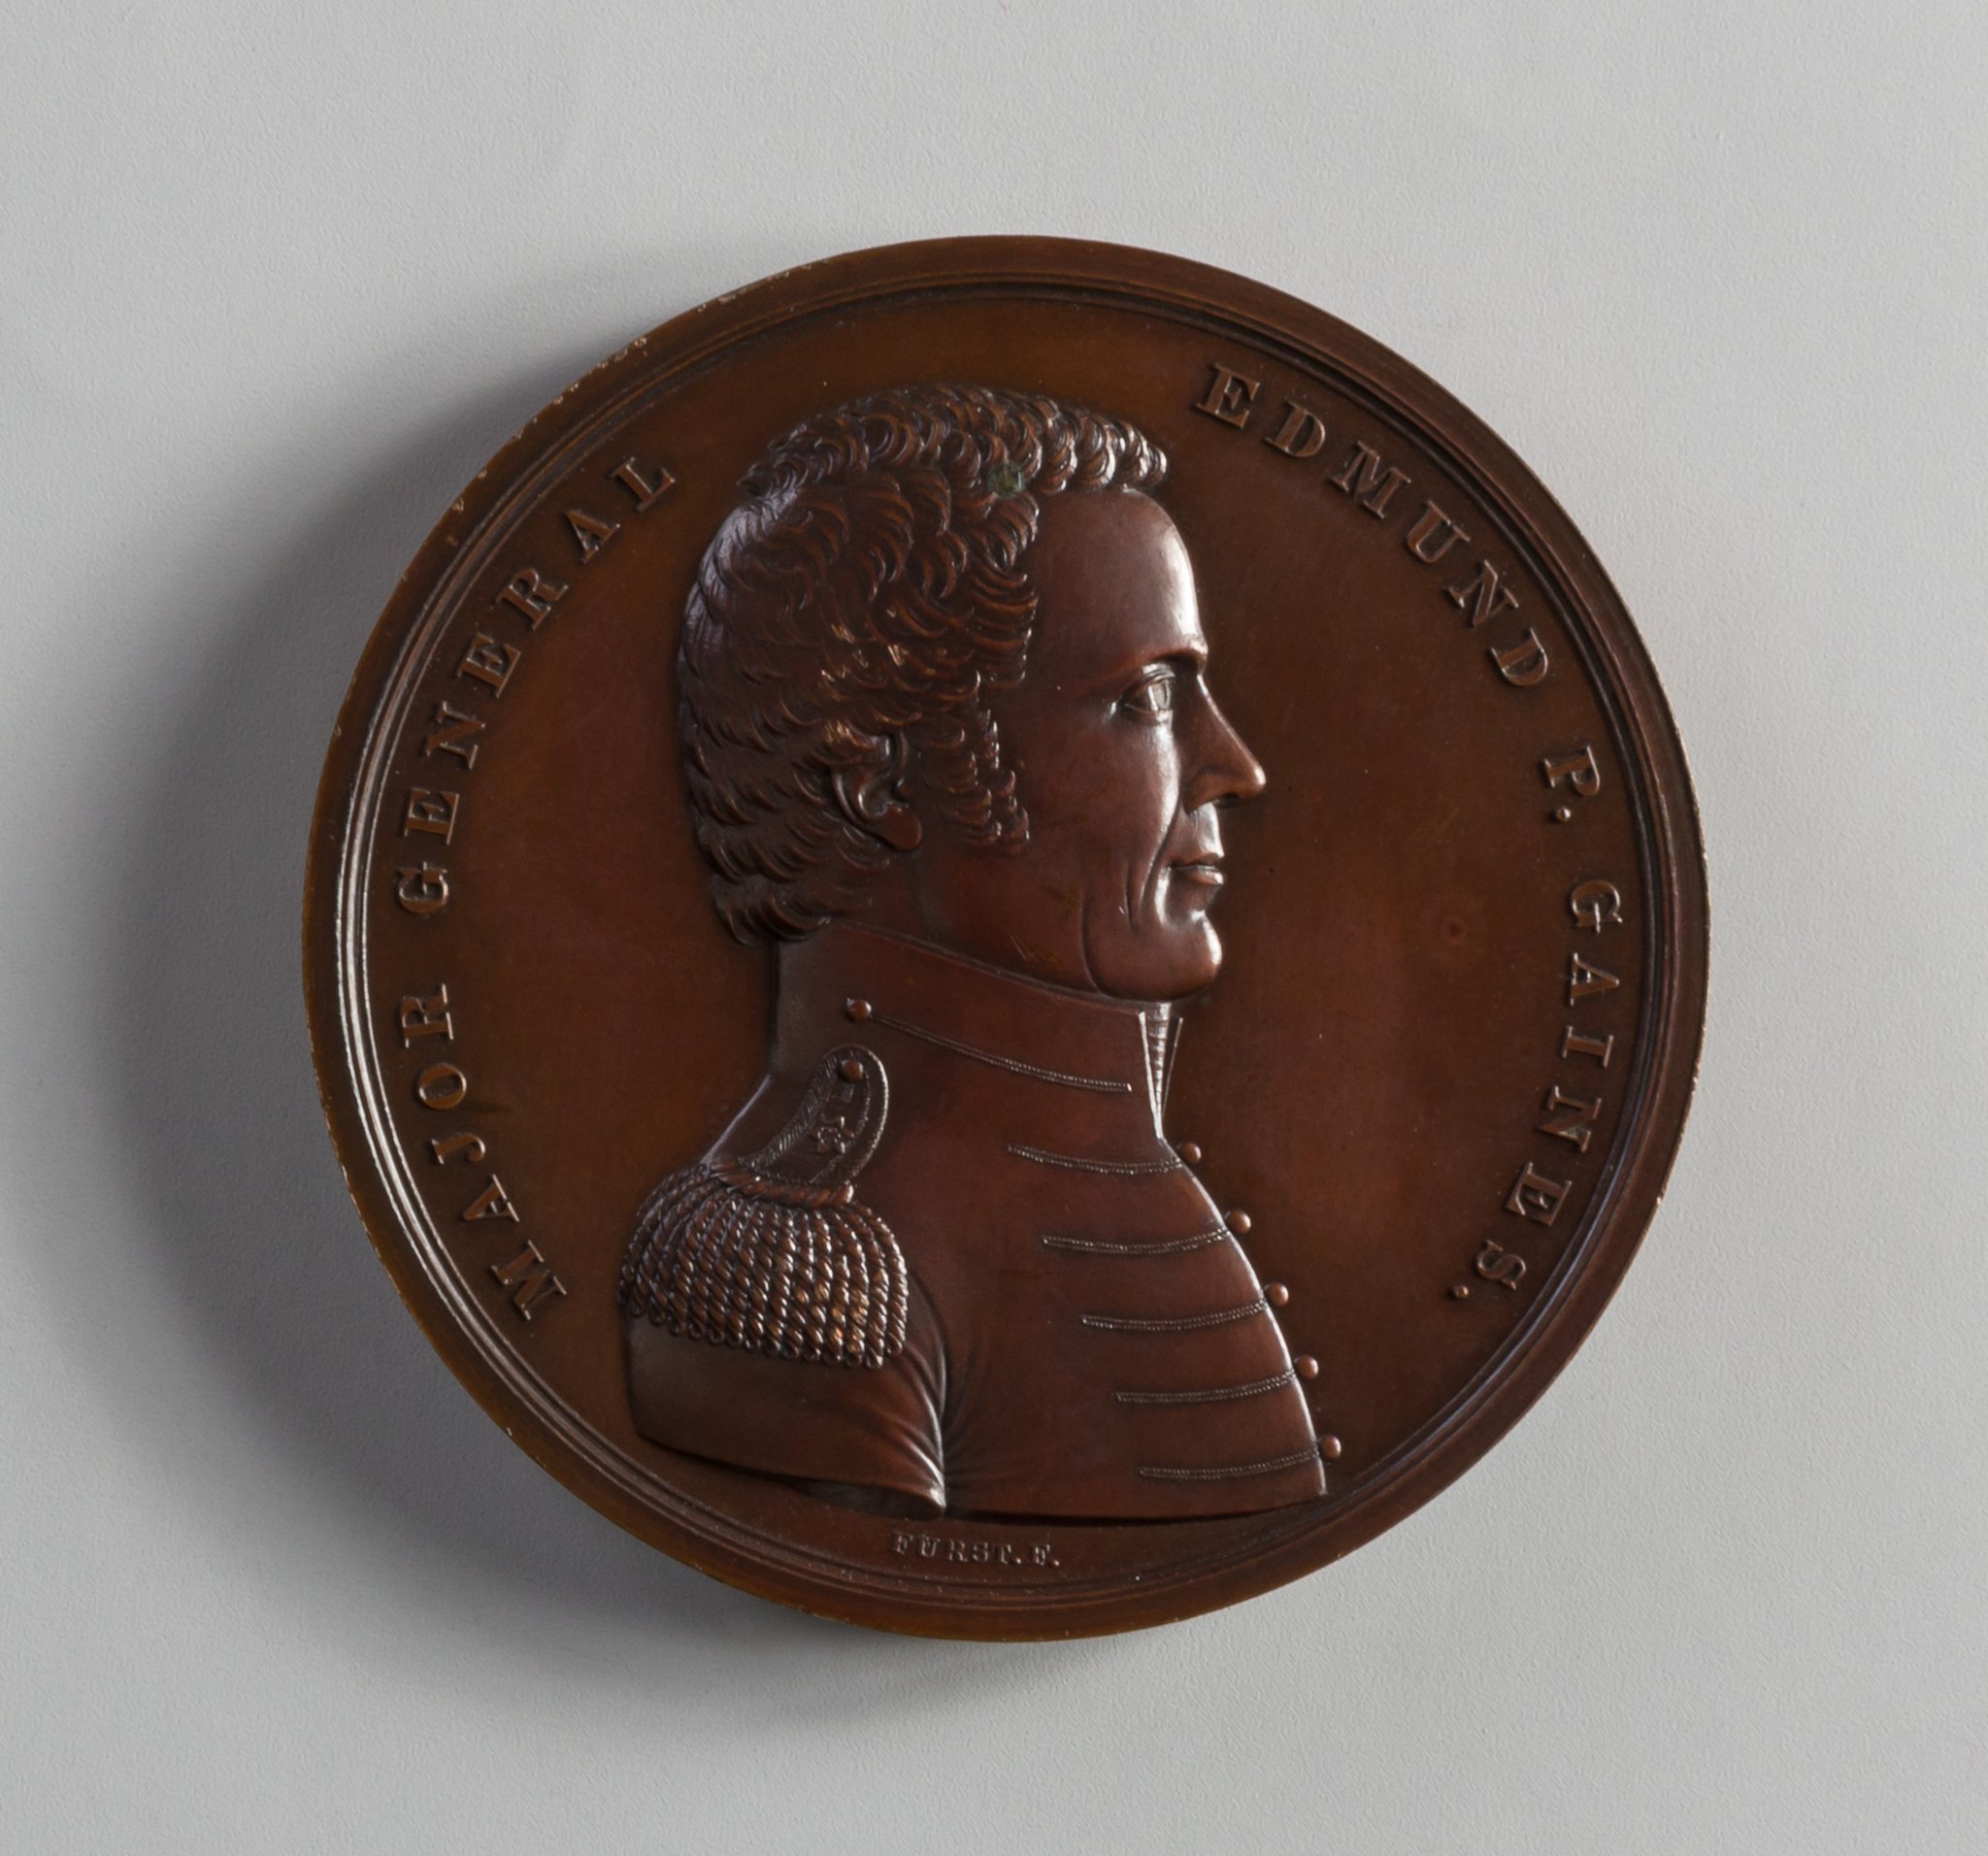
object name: medal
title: Medal of Major General E. P. Gaines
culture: american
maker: moritz fürst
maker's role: maker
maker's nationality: hungarian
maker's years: 1782-1882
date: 1800-1830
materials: bronze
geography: united states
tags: men,profiles